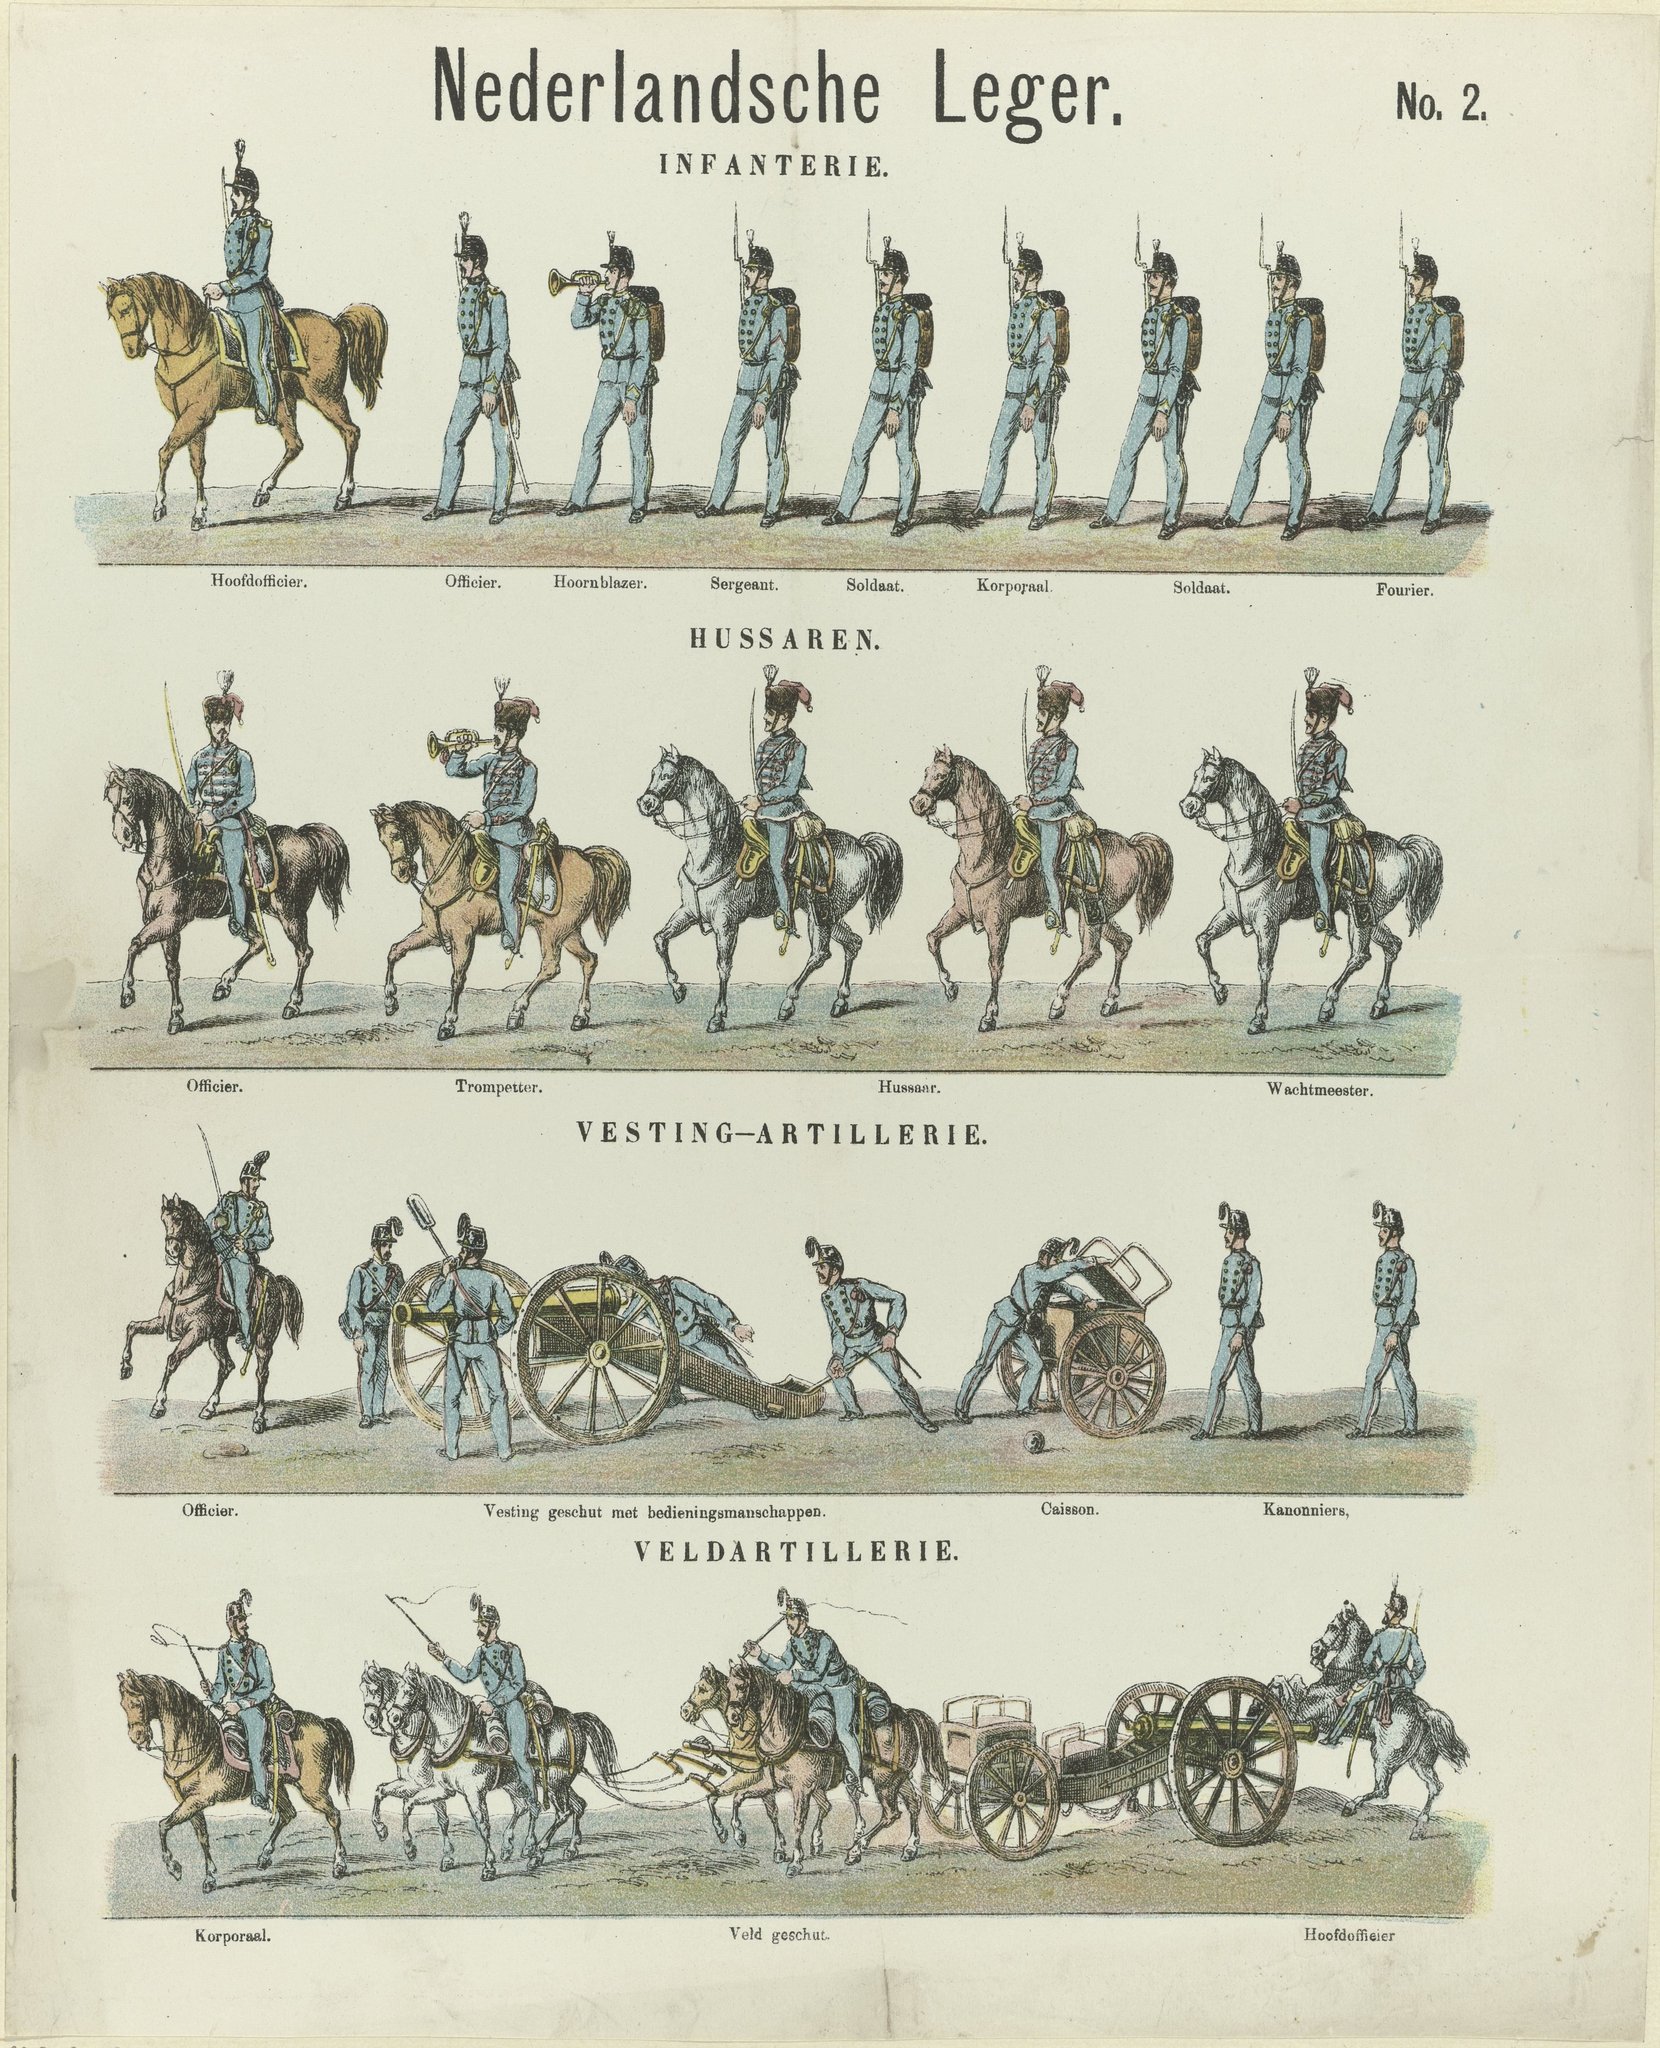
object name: popular print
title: Meijer's prenten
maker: Anonymous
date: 1873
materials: paper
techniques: lithograph, letterpress printing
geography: amsterdam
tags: warfare; military affairs (+ cavalry, horsemen), the soldier; the soldier's life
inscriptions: collector's mark: Lugt 2760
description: Blad met 4 horizontale rijen met voorstellingen van Nederlandse militairen. Onder elke afbeelding een onderschrift. Genummerd rechtsboven: No. 2.